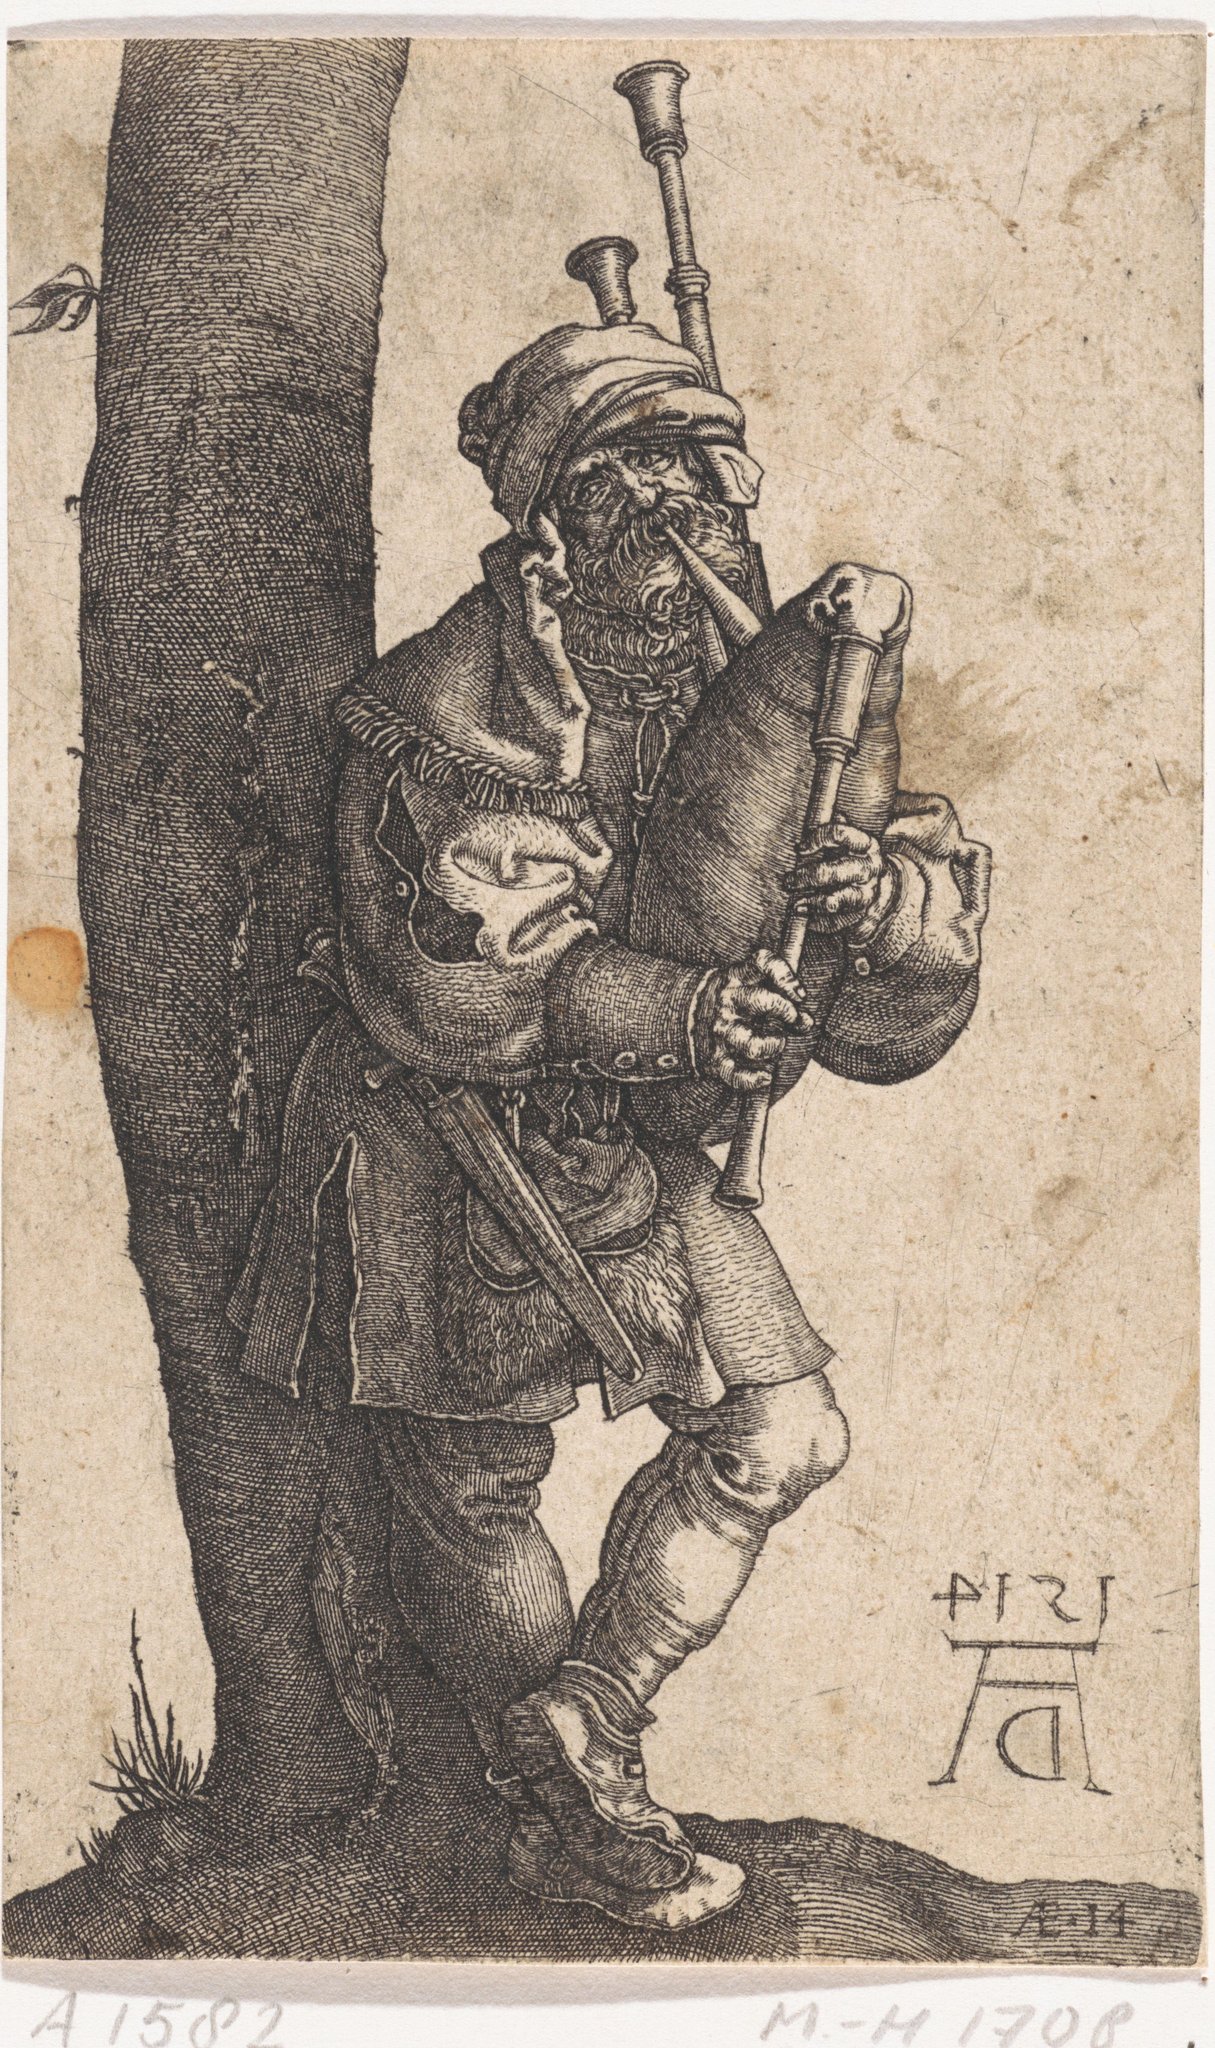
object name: print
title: De doedelzakspeler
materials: paper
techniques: engraving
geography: antwerp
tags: one person playing wind instrument, bagpipe, musette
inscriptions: collector's mark: Lugt 2228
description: Een man speelt doedelzak, leunend tegen een boom. Rechtsonder het monogram van Albrecht Dürer en de datering van diens prent in spiegelbeeld. Gesigneerd met "Æ14".